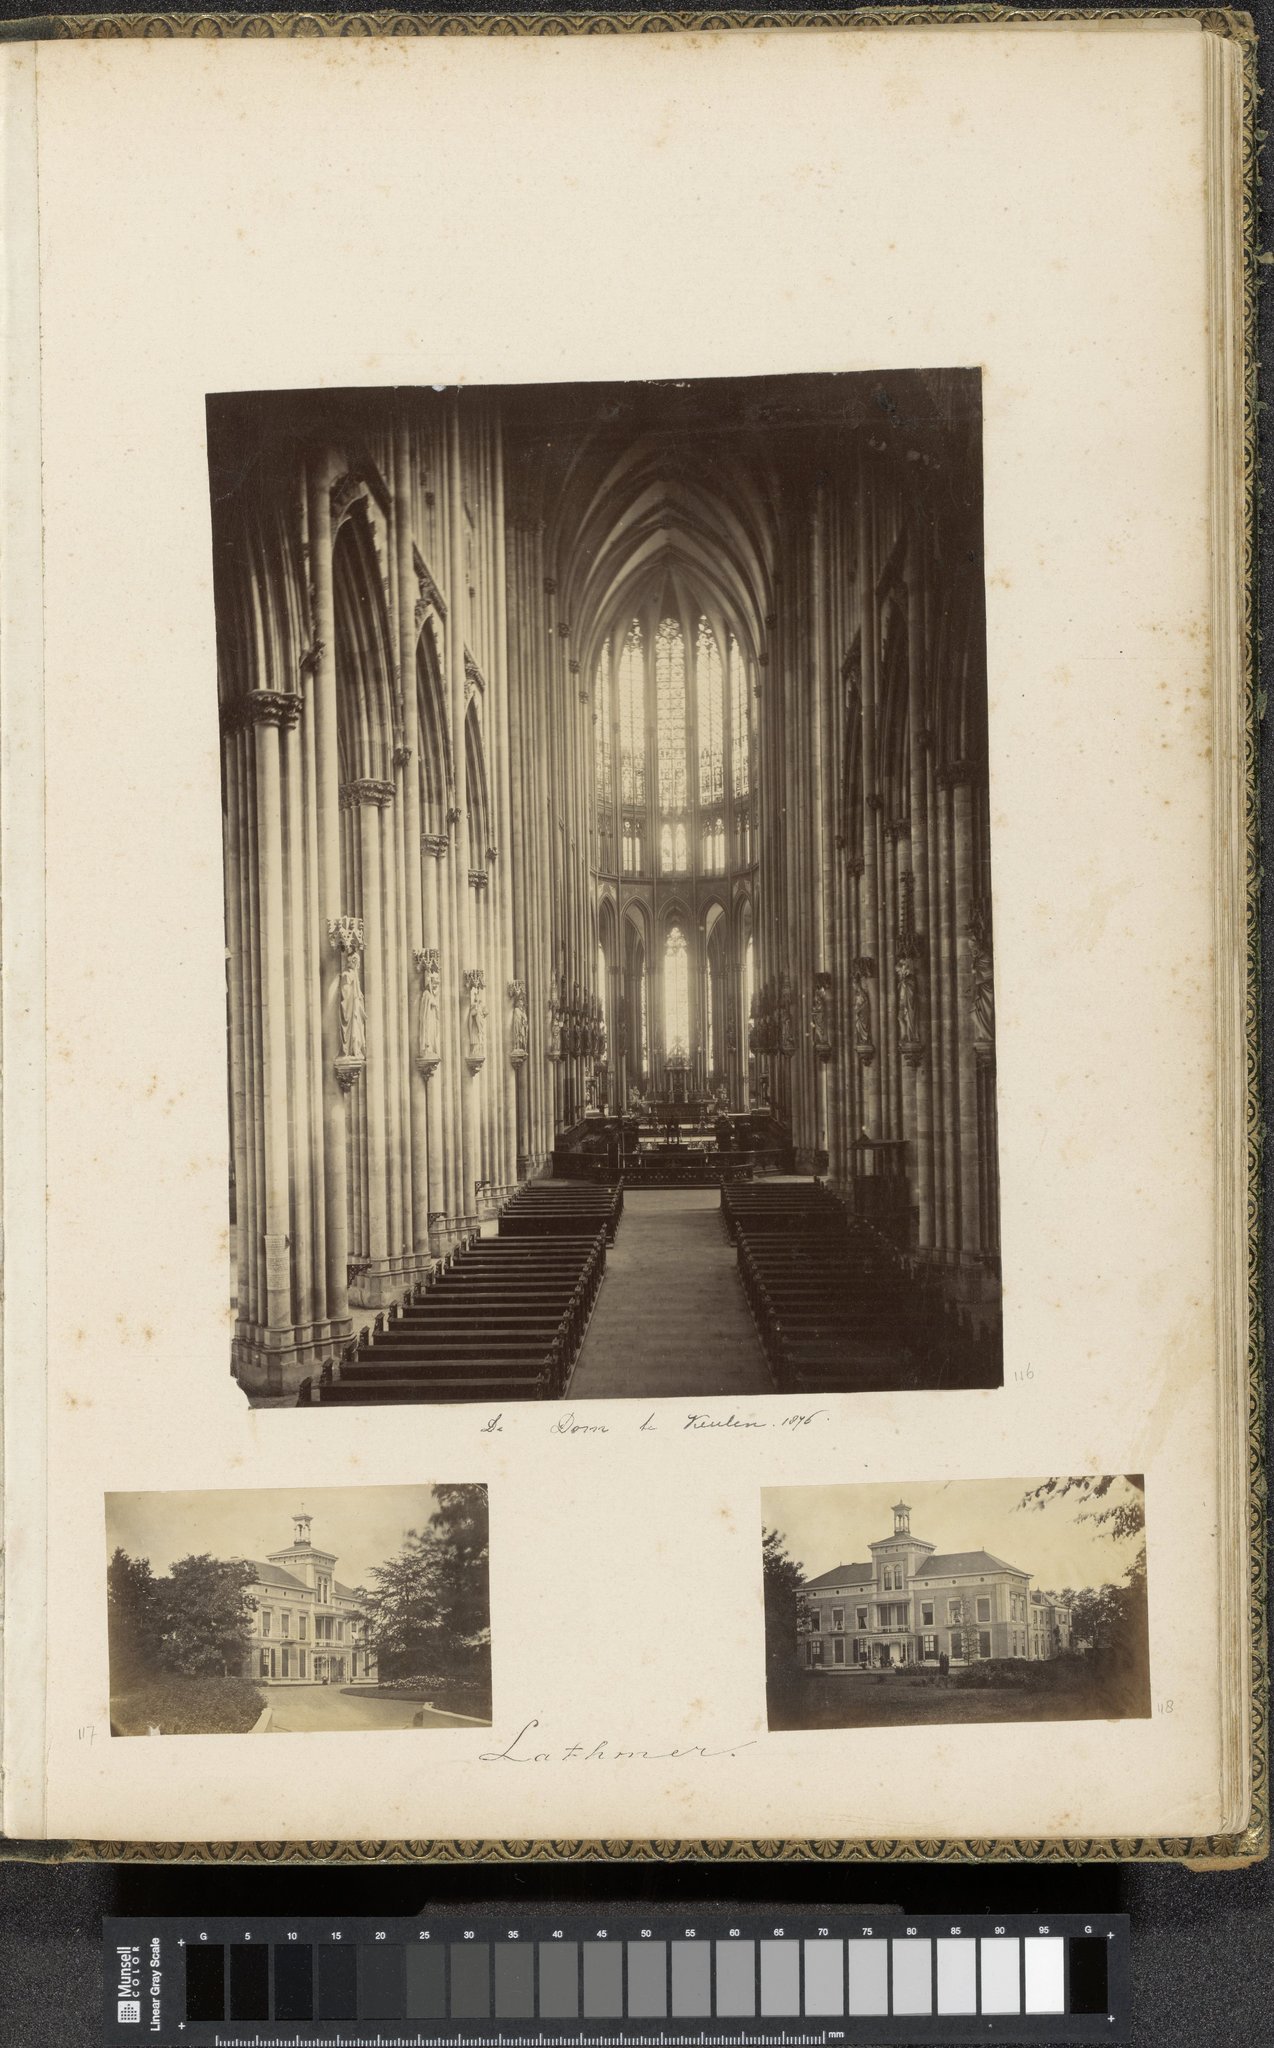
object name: album leaf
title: Interieur van de Dom van Keulen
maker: Anonymous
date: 1876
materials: paper, photographic support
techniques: albumen print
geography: cologne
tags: parts of church interior: nave, cologne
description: Onderdeel van Fotoalbum van Robert Daniel Crommelin (1841-1907).